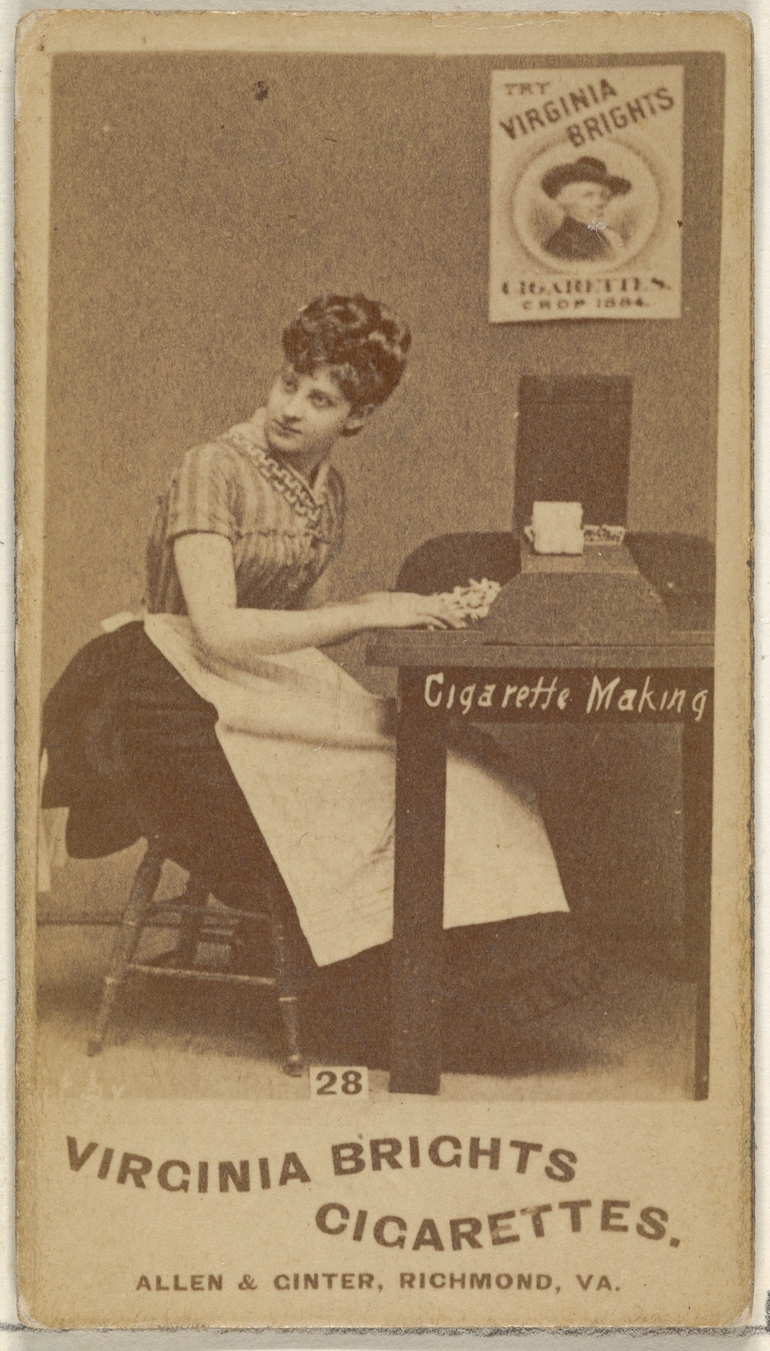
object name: photograph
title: Card 28, from the series, Cigarette Making Girls (N46) for Virginia Brights Cigarettes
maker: allen & ginter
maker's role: publisher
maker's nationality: american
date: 1888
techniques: albumen silver print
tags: women